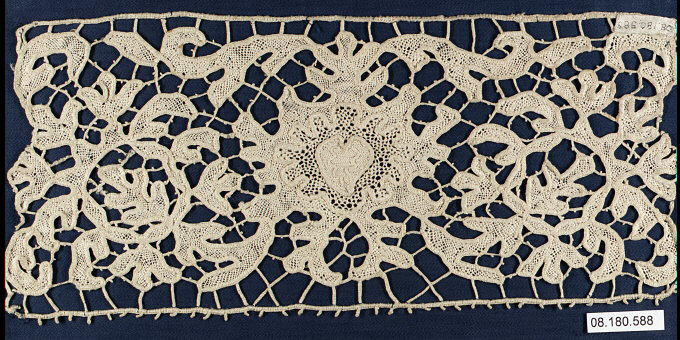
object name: border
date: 1701-1800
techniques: lace